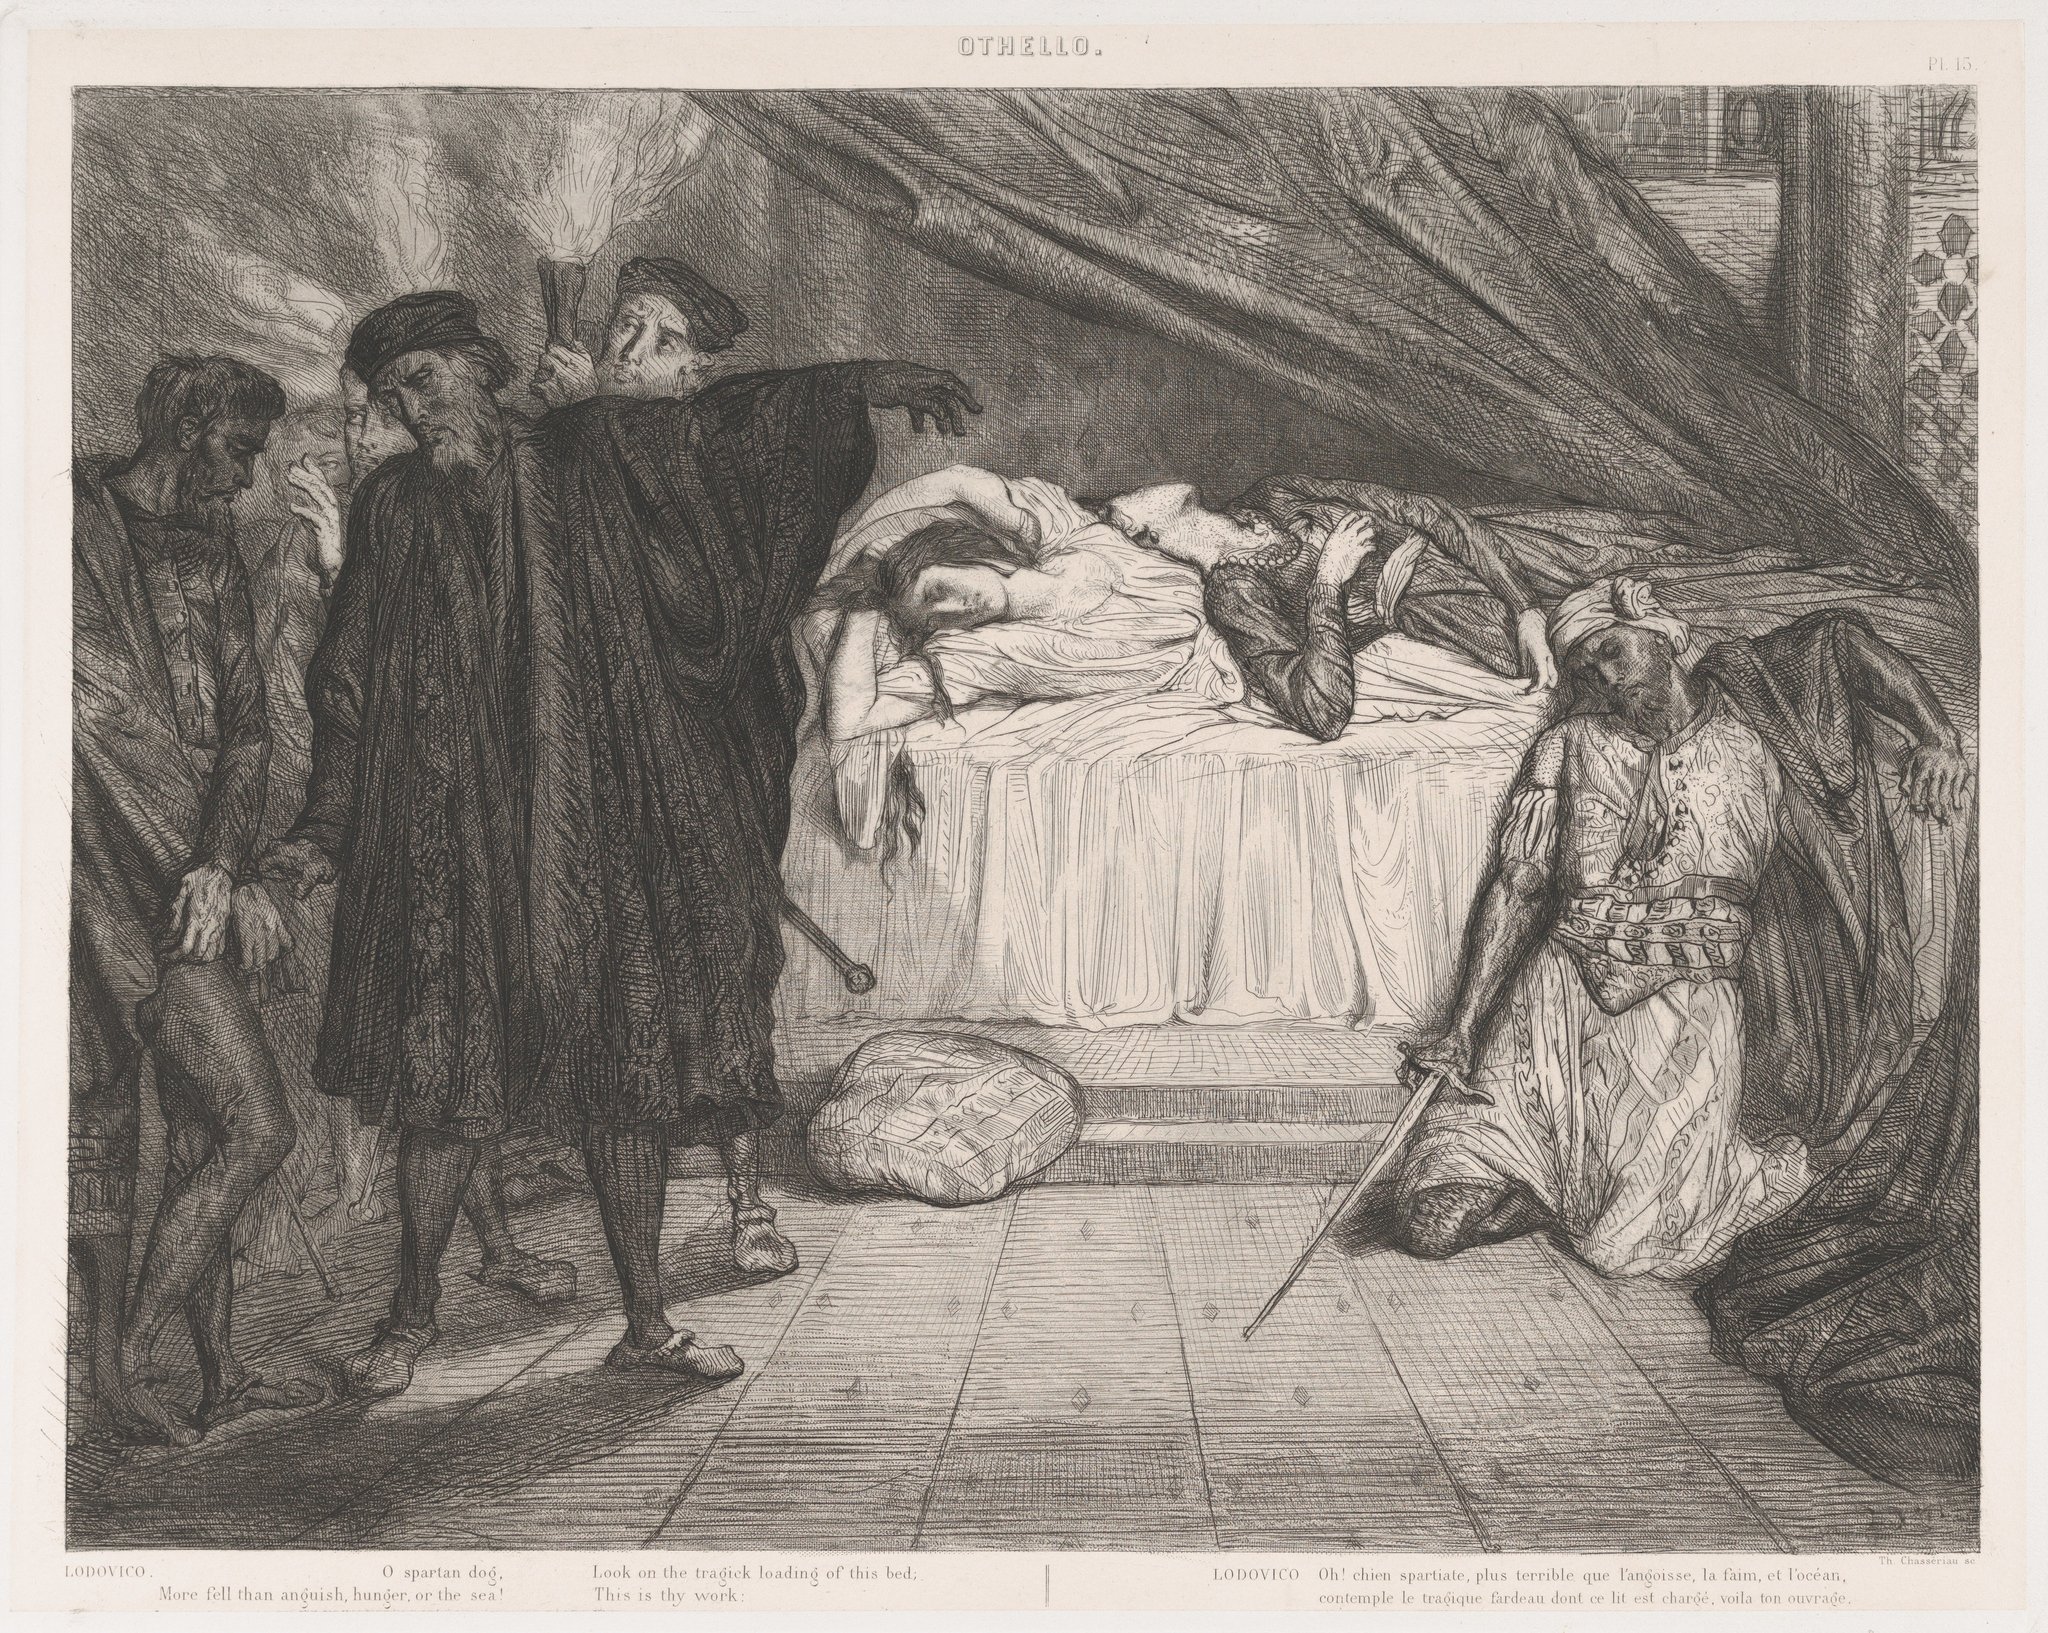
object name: print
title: "O Spartan dog": plate 15 from Othello (Act 5, Scene 2)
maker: théodore chassériau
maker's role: artist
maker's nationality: french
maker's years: 1819-1856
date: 1844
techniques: aquatint, printmaking, drypoint, engraving, etching, roulette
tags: swords,shakespeare,men,women,death,beds